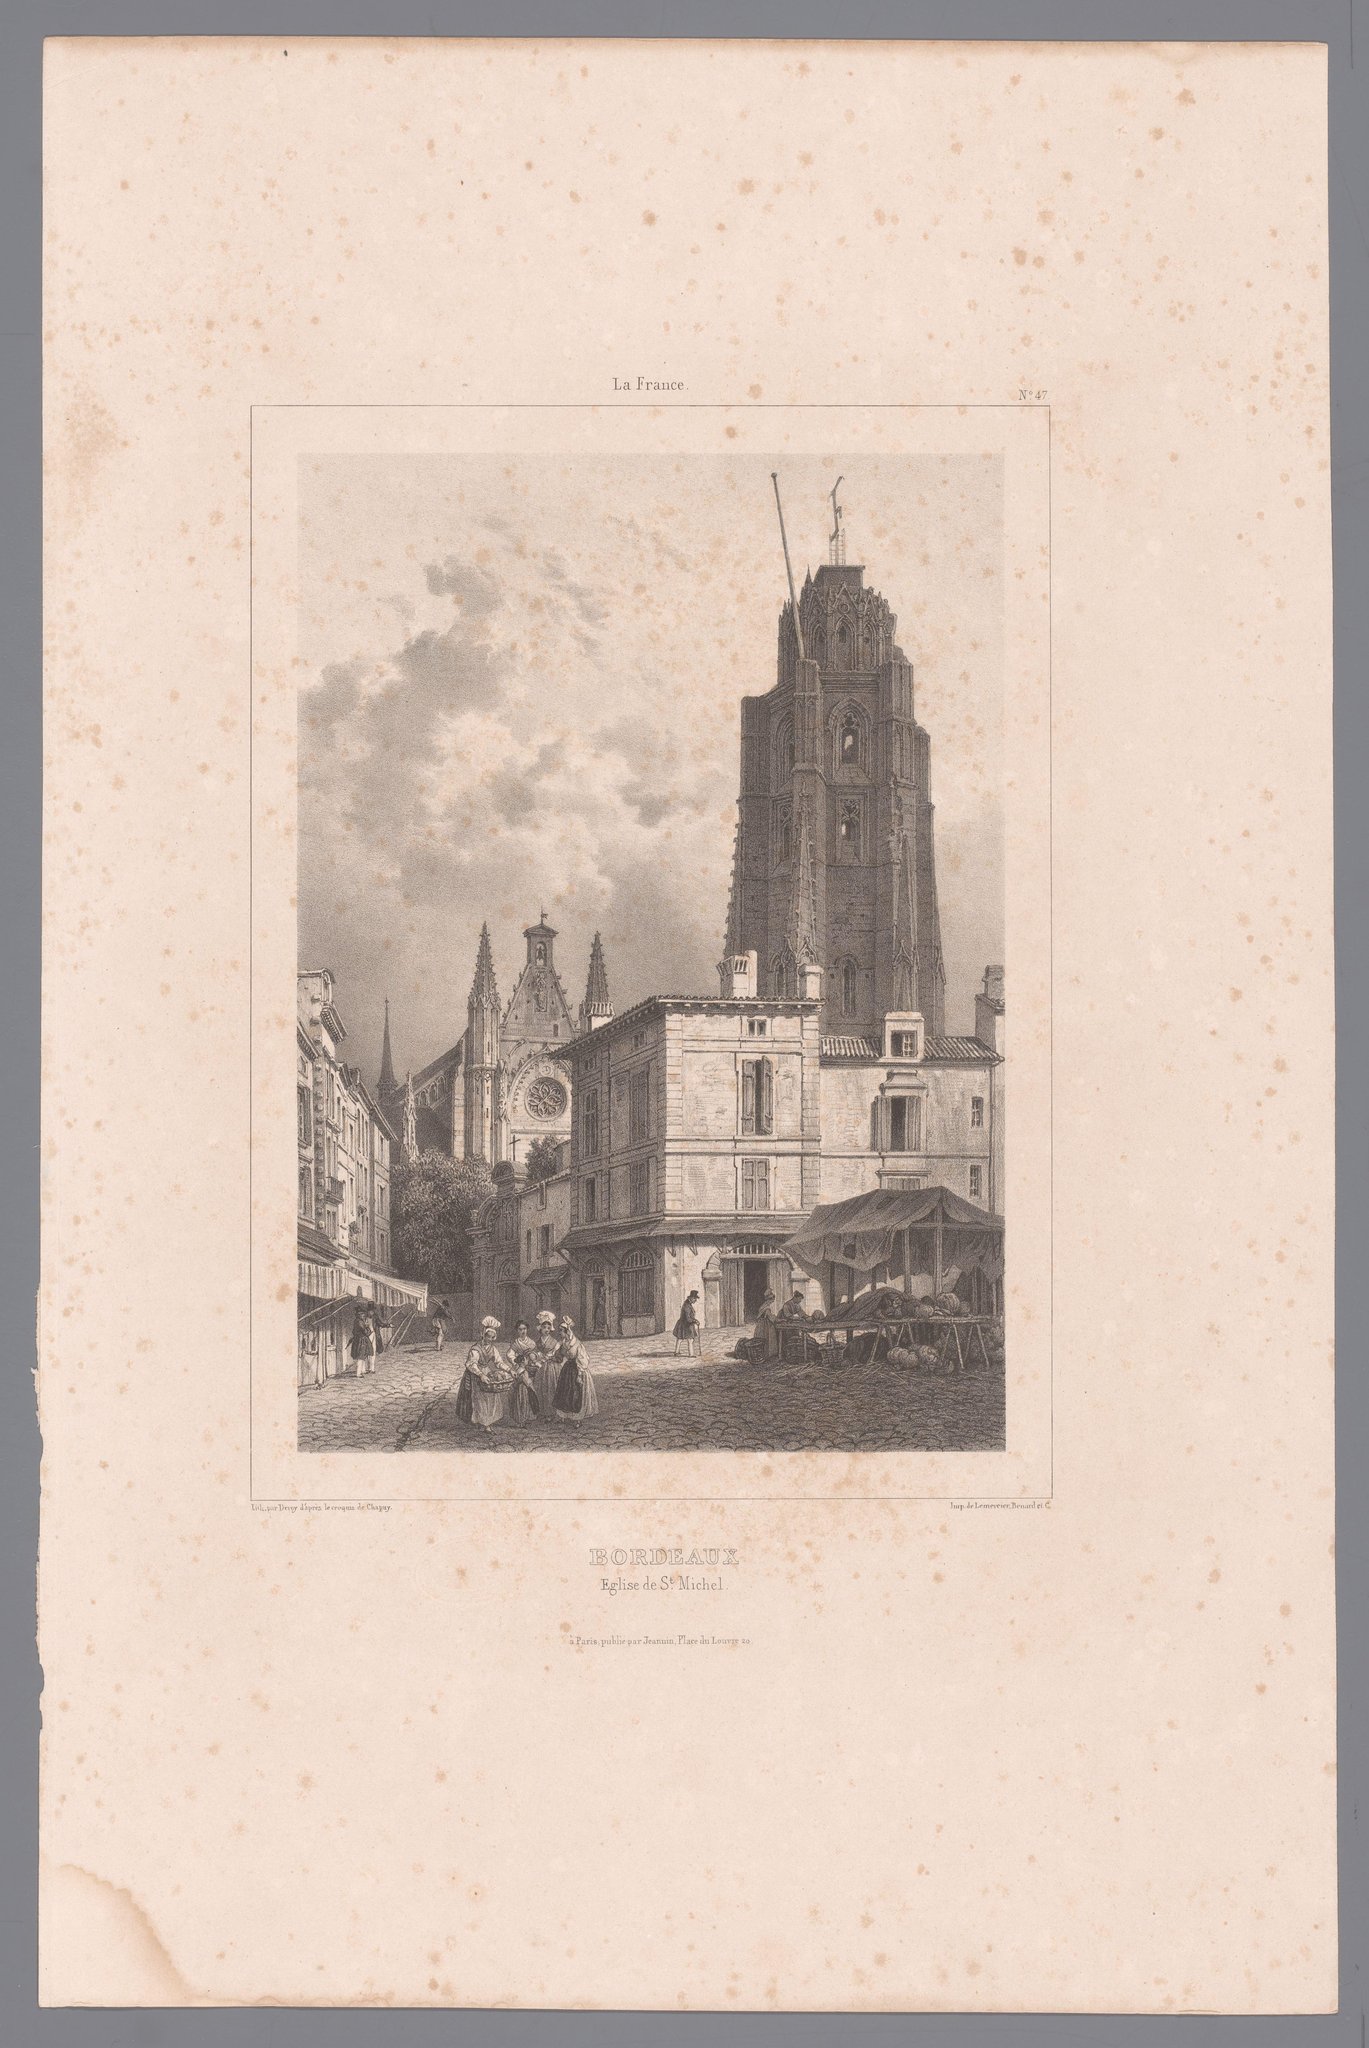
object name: print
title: Gezichten in Frankrijk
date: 1834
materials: paper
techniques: lithograph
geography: bordeaux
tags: church (exterior), tower, clock tower ~ monumental adornment (+ city(-scape) with figures, staffage)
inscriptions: check stamp: Lugt 1397c, collector's mark: Lugt 2228a